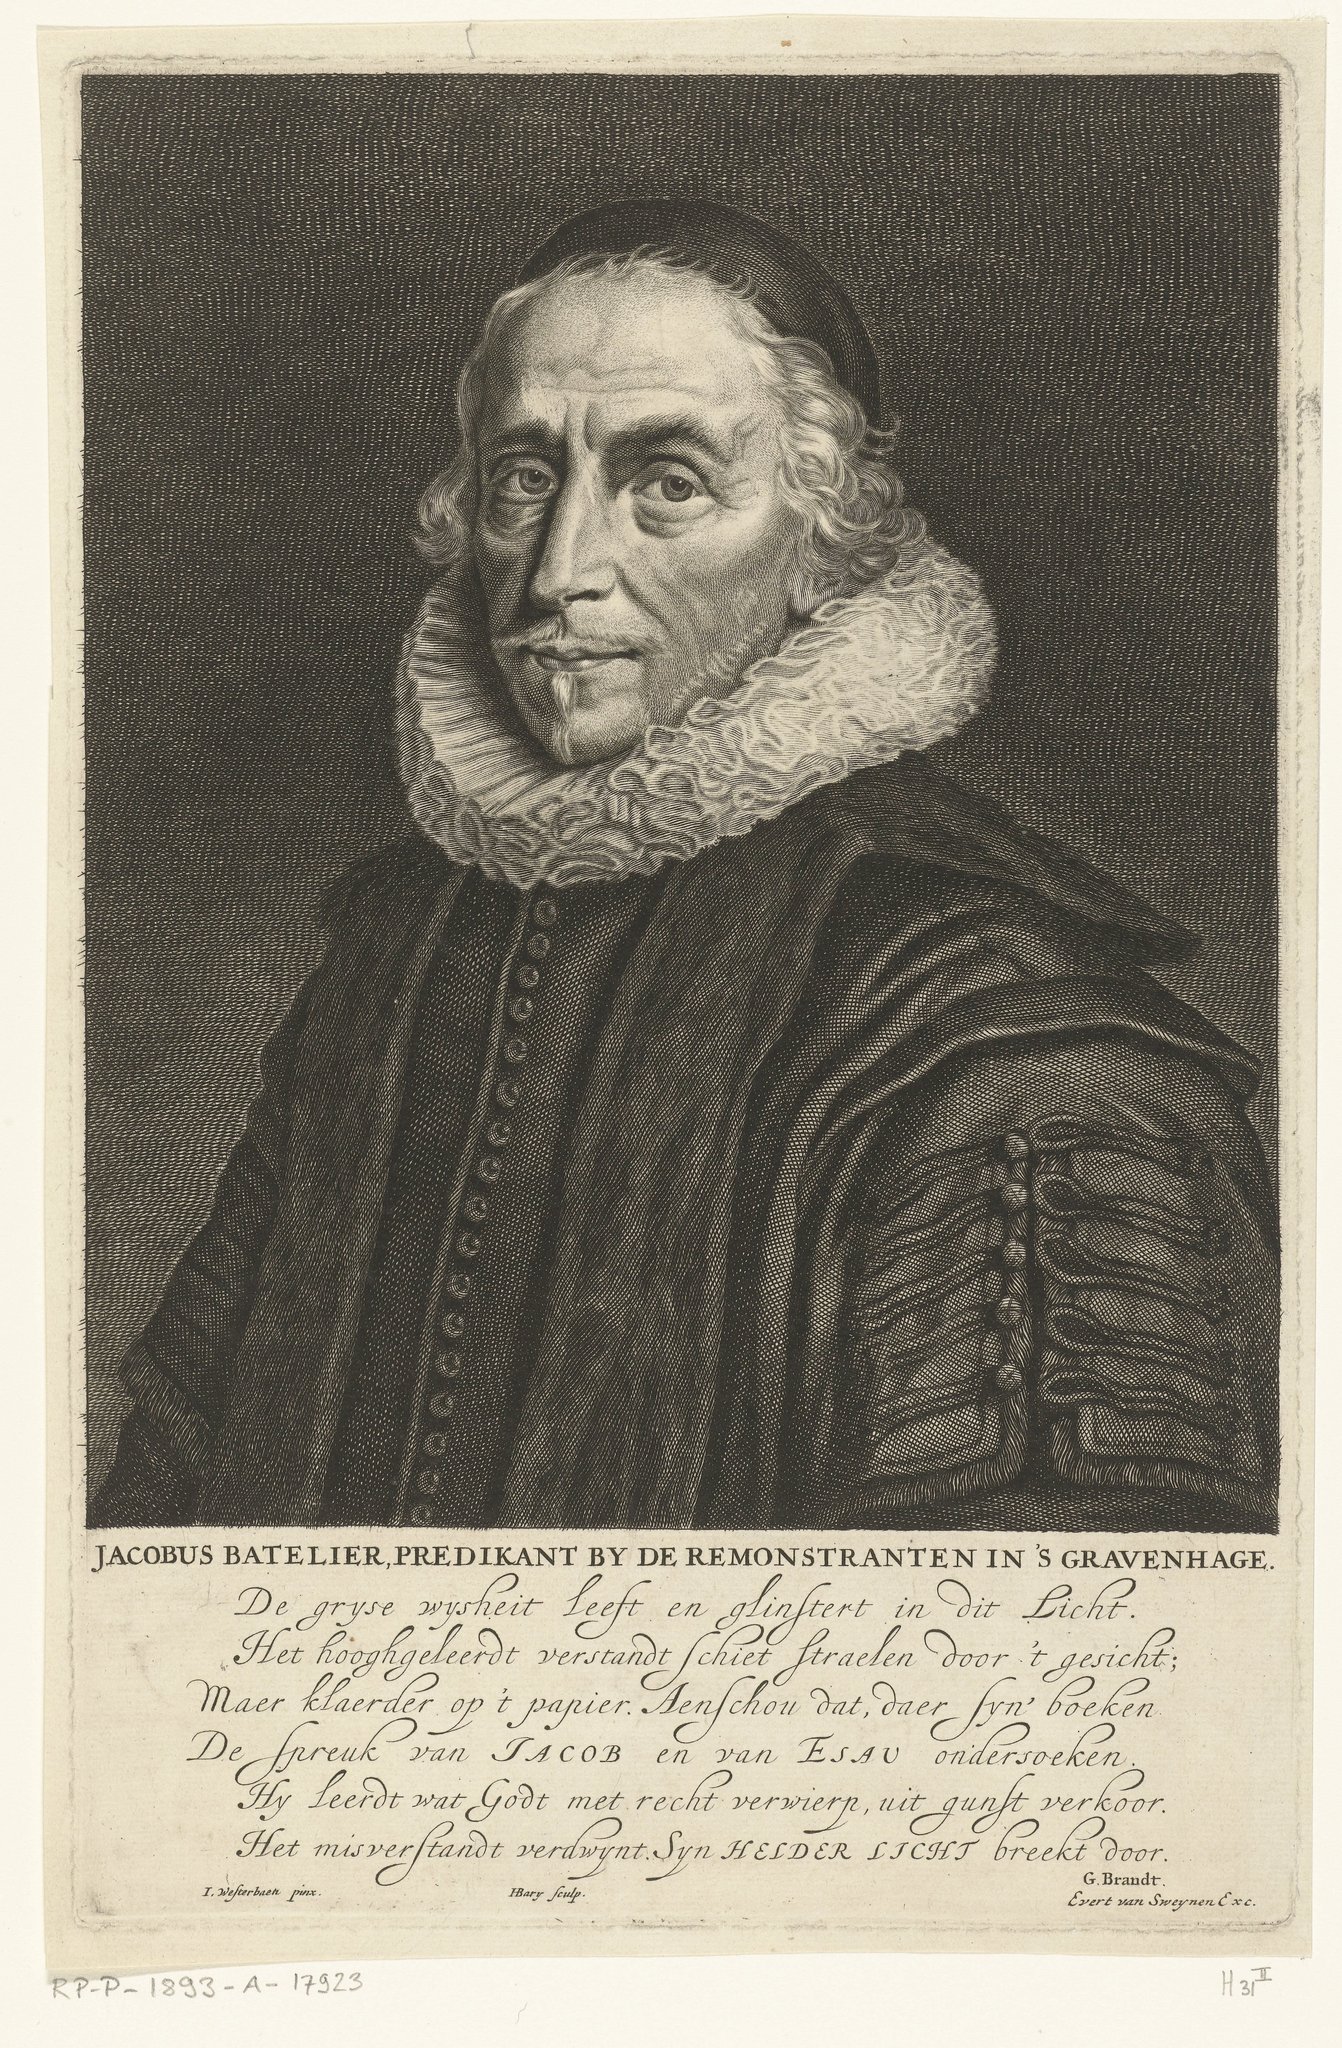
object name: print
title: Portret van Jacob Johannes Batelier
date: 1657-1707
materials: paper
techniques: engraving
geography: netherlands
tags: predikant, jacobus johannes batelier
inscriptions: collector's mark: Lugt 2228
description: Portretbuste van de remonstrantse predikant Jacobus Johannes Batelier. Onder de voorstelling een vers van zes regels in het Nederlands.